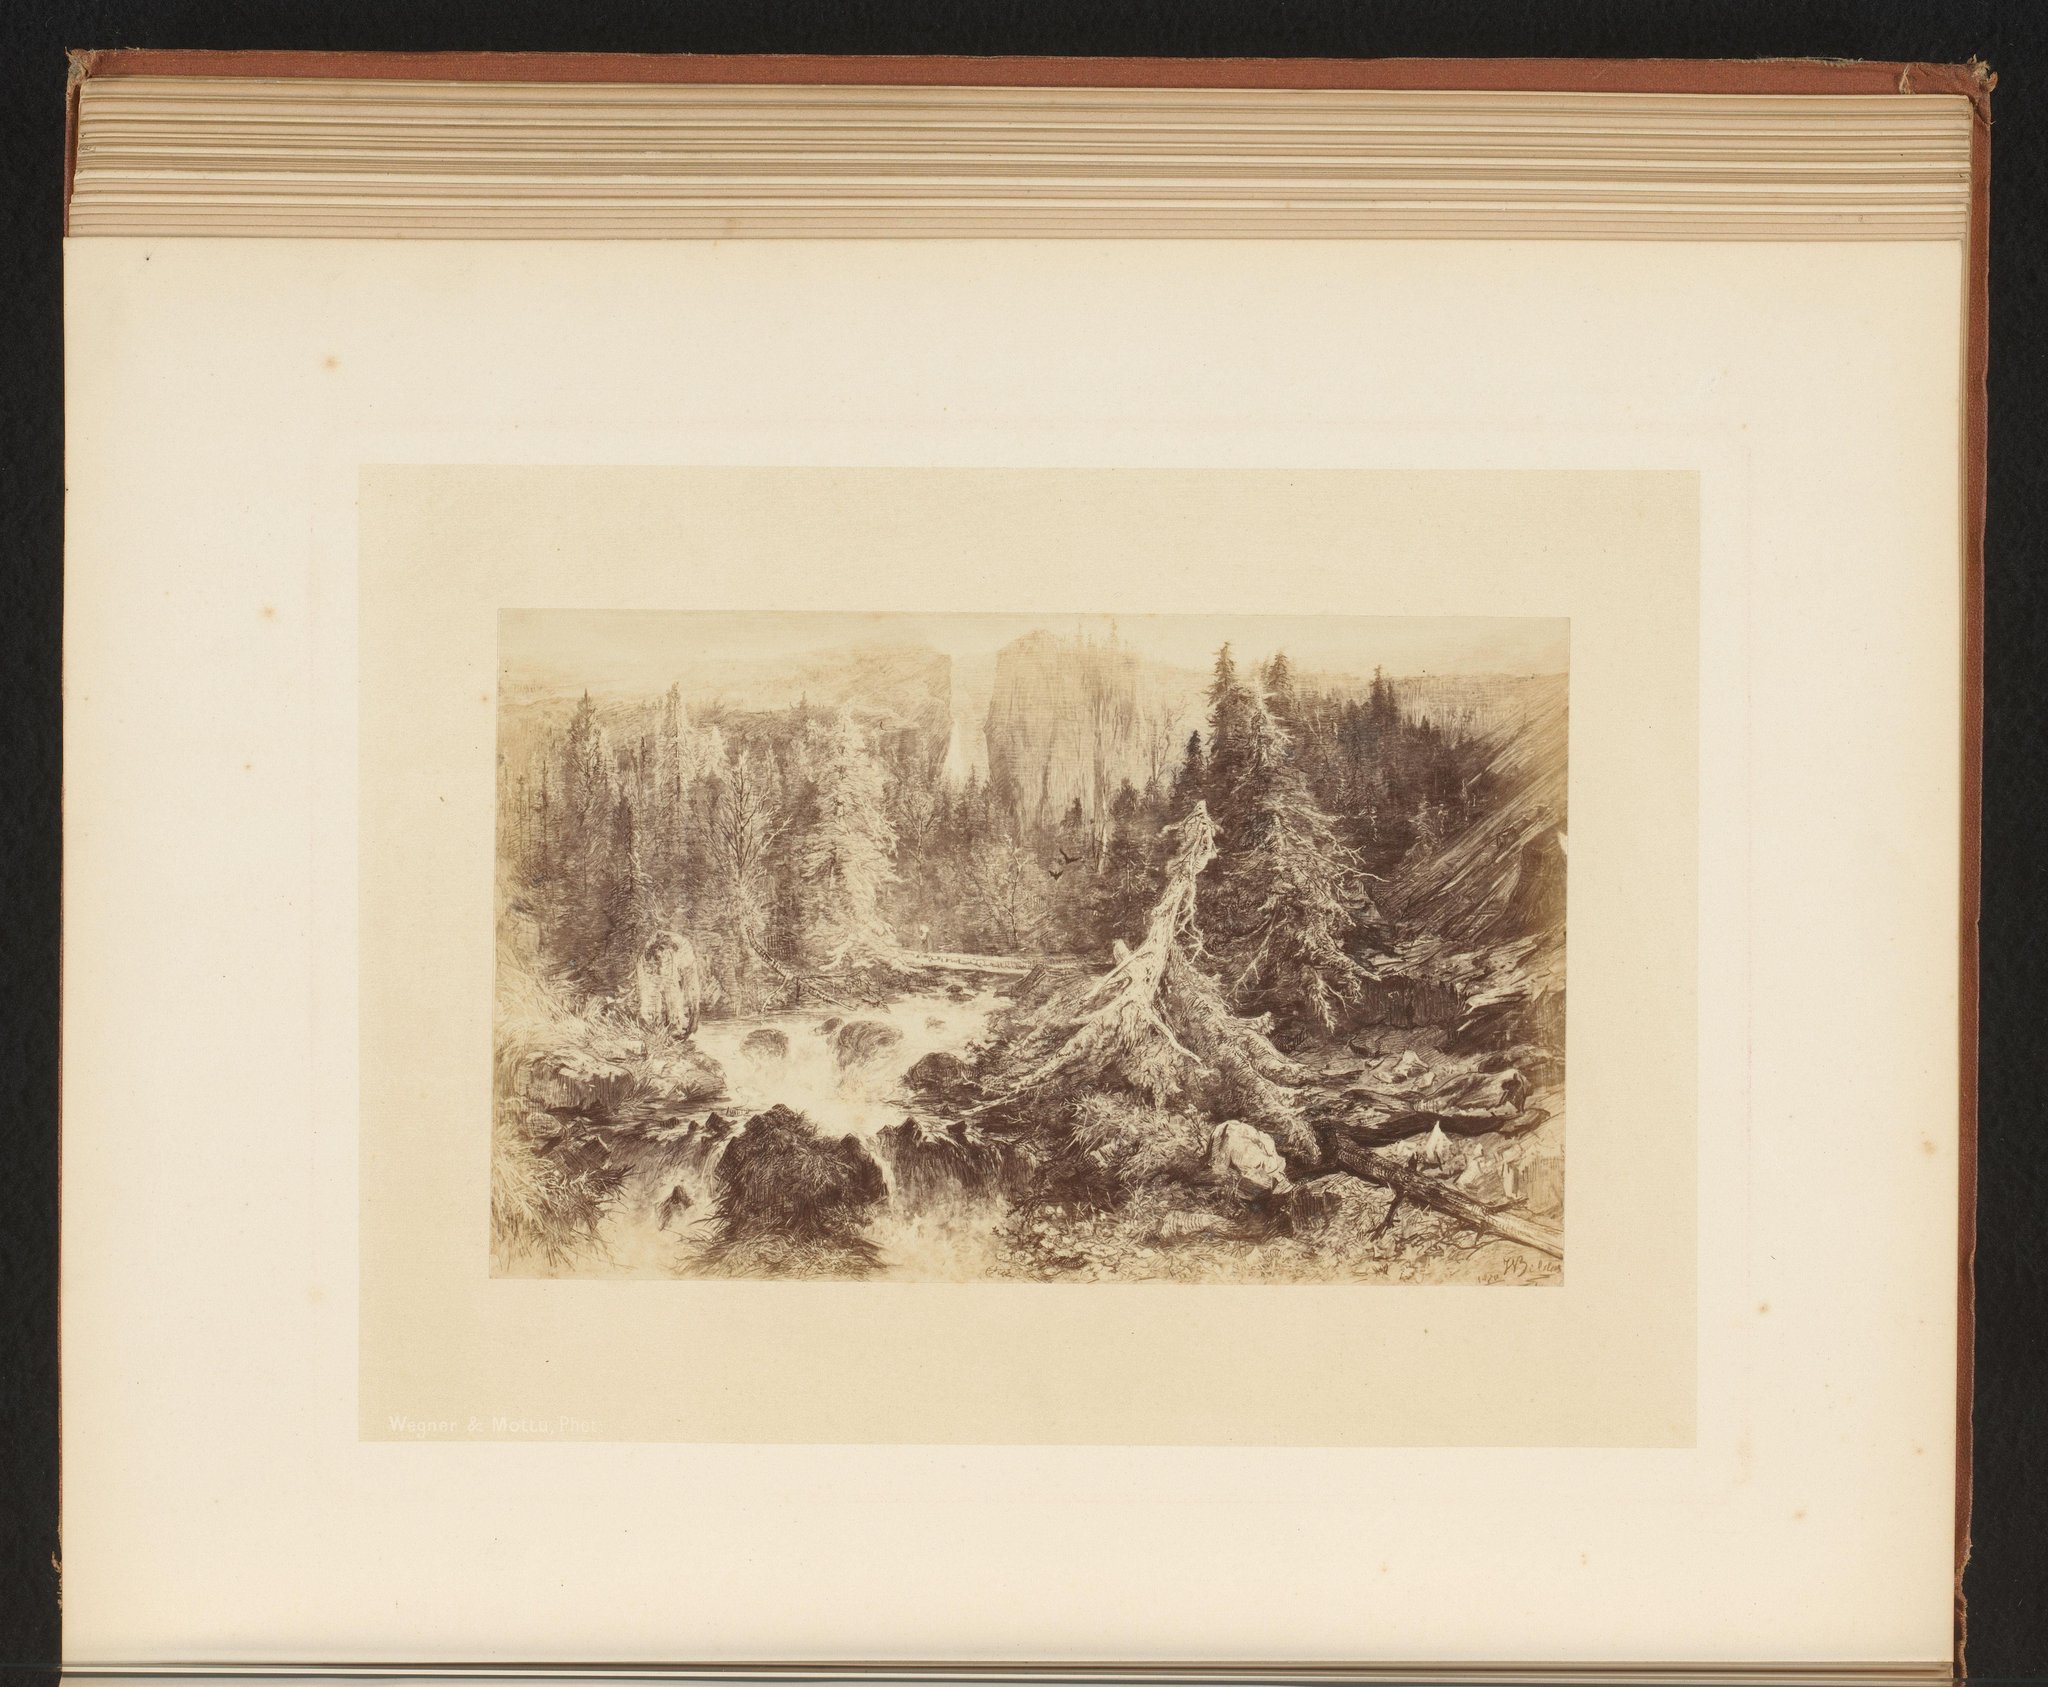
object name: photograph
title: Fotoreproductie van een gravure naar een schilderij van het Zwarte Woud door Johannes Warnardus Bilders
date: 1866-1871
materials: paper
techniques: albumen print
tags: print, e.g.: engraving, etching, lithograph, forest, wood